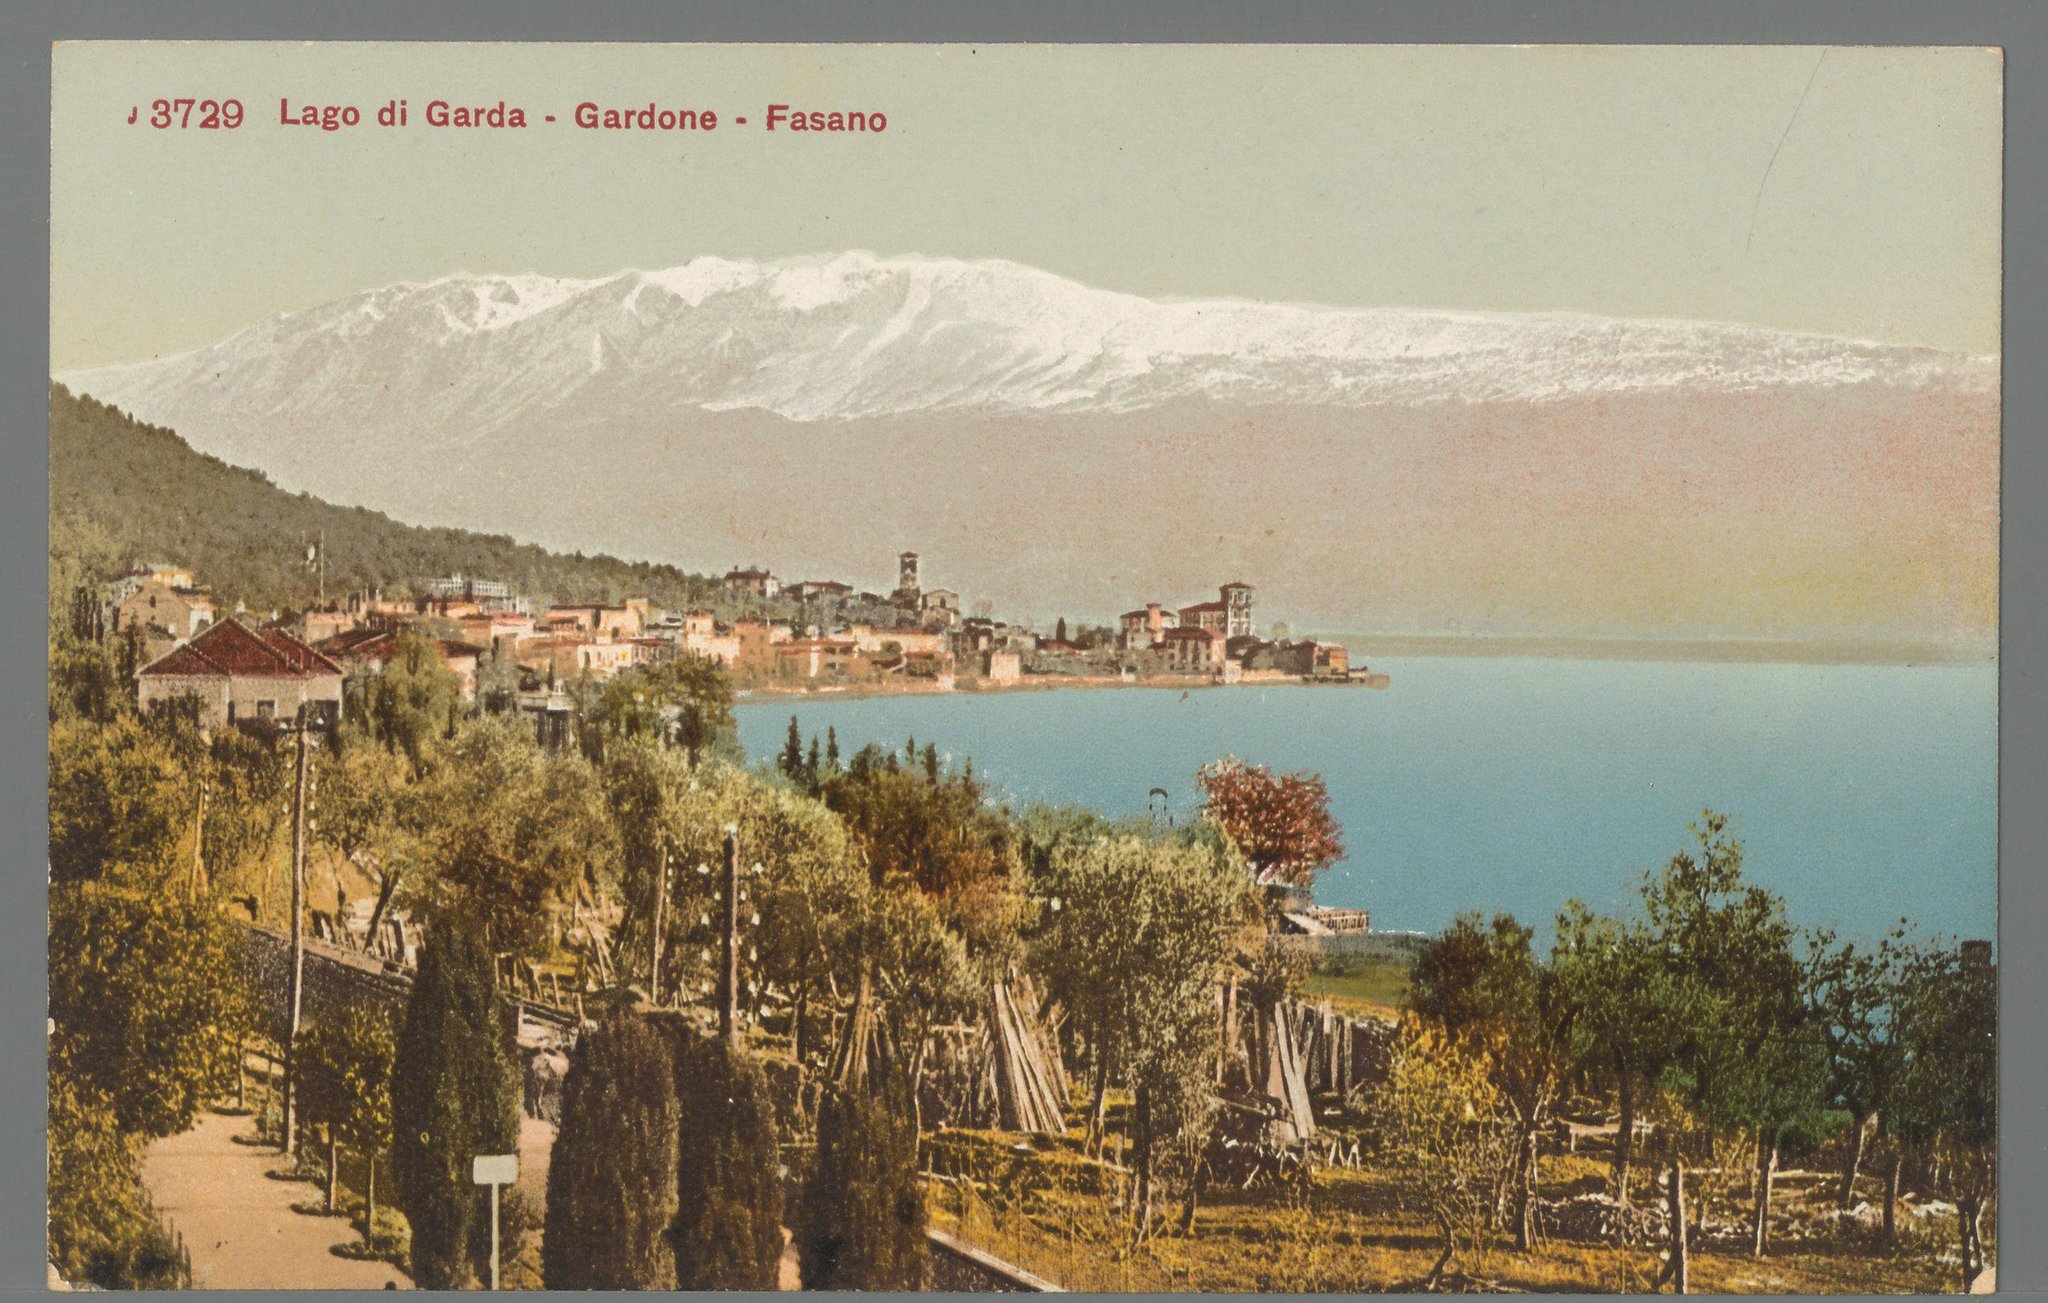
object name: photomechanical print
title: Lago di Garda. Gardone-Fasano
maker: Anonymous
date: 1905-1930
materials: cardboard, photographic process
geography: zurich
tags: prospect of village, silhouette of village, lake, mountains